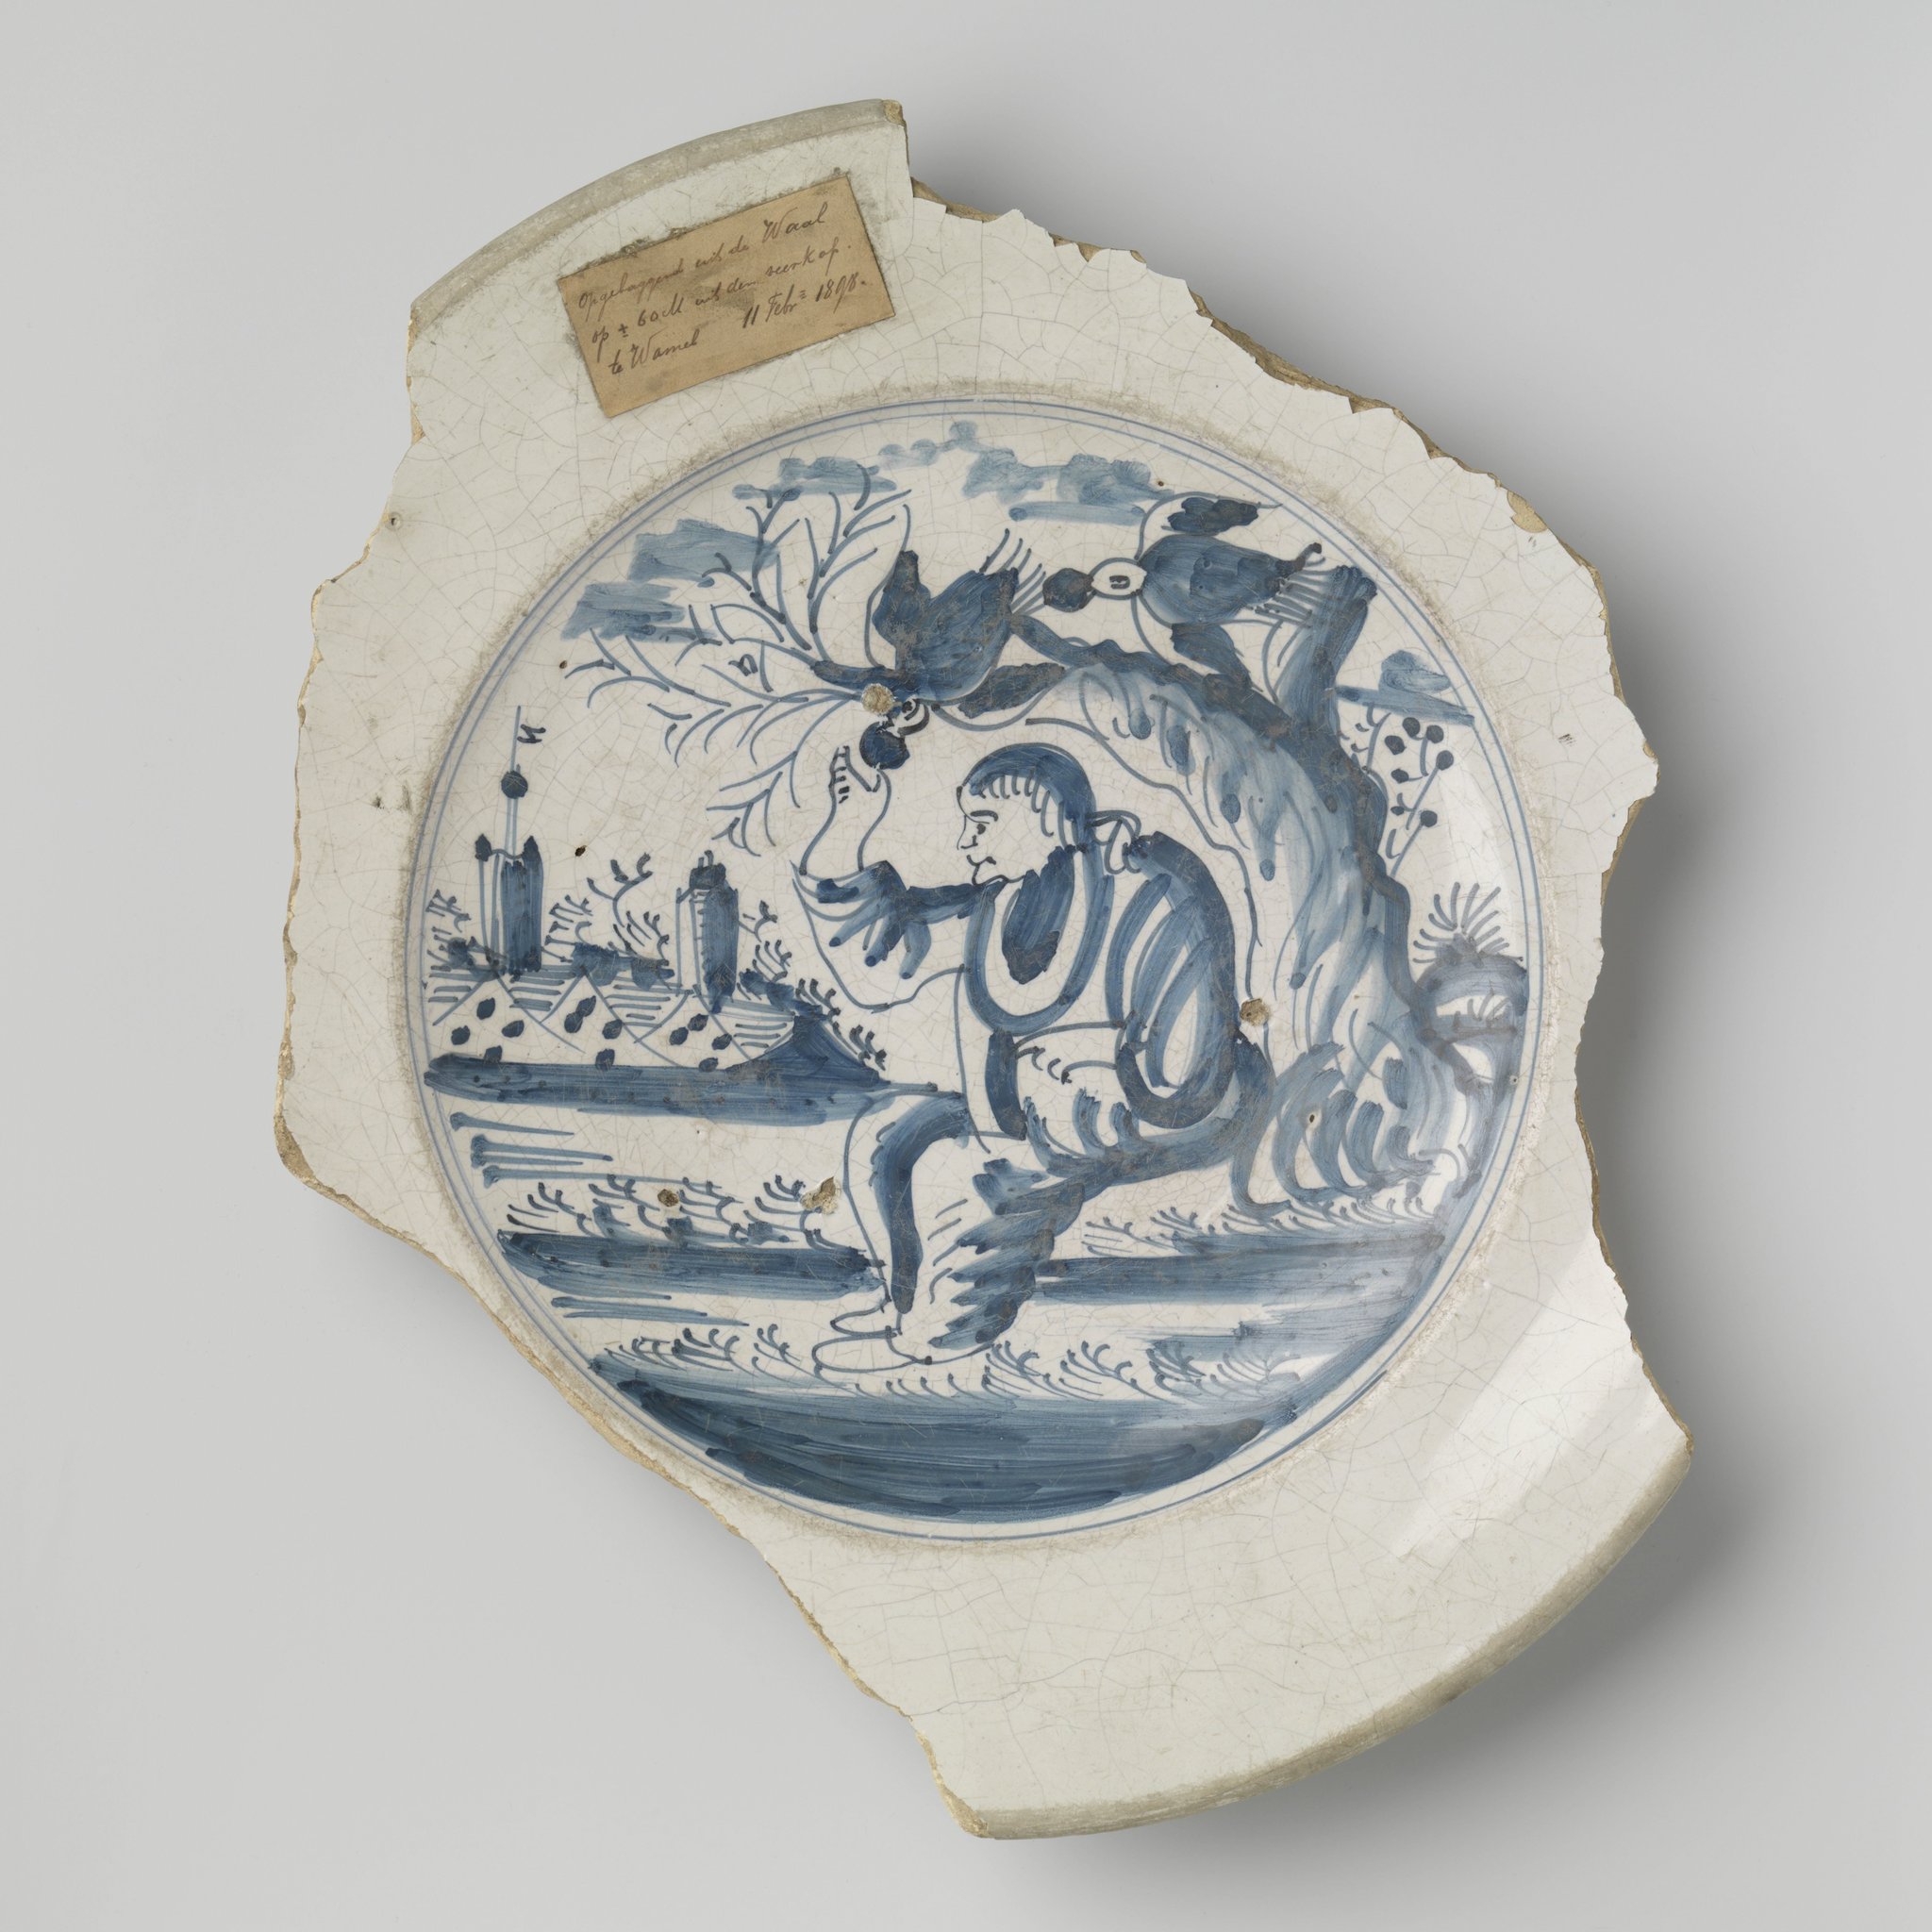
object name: fragment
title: Fragment van een schotel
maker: Anonymous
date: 1700-1740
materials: earthenware, glaze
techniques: maiolica, painted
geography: friesland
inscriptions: inscription: ‘Opgebaggerd uit de Waal. op [plusminus] 60 M uit den [...] te Wamel. 11 Febr. 1898’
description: Fragment van een schotel van blauw beschilderde majolica. Op het plat is een voorstelling geschilderd van Elias die door de raven gegeten wordt.